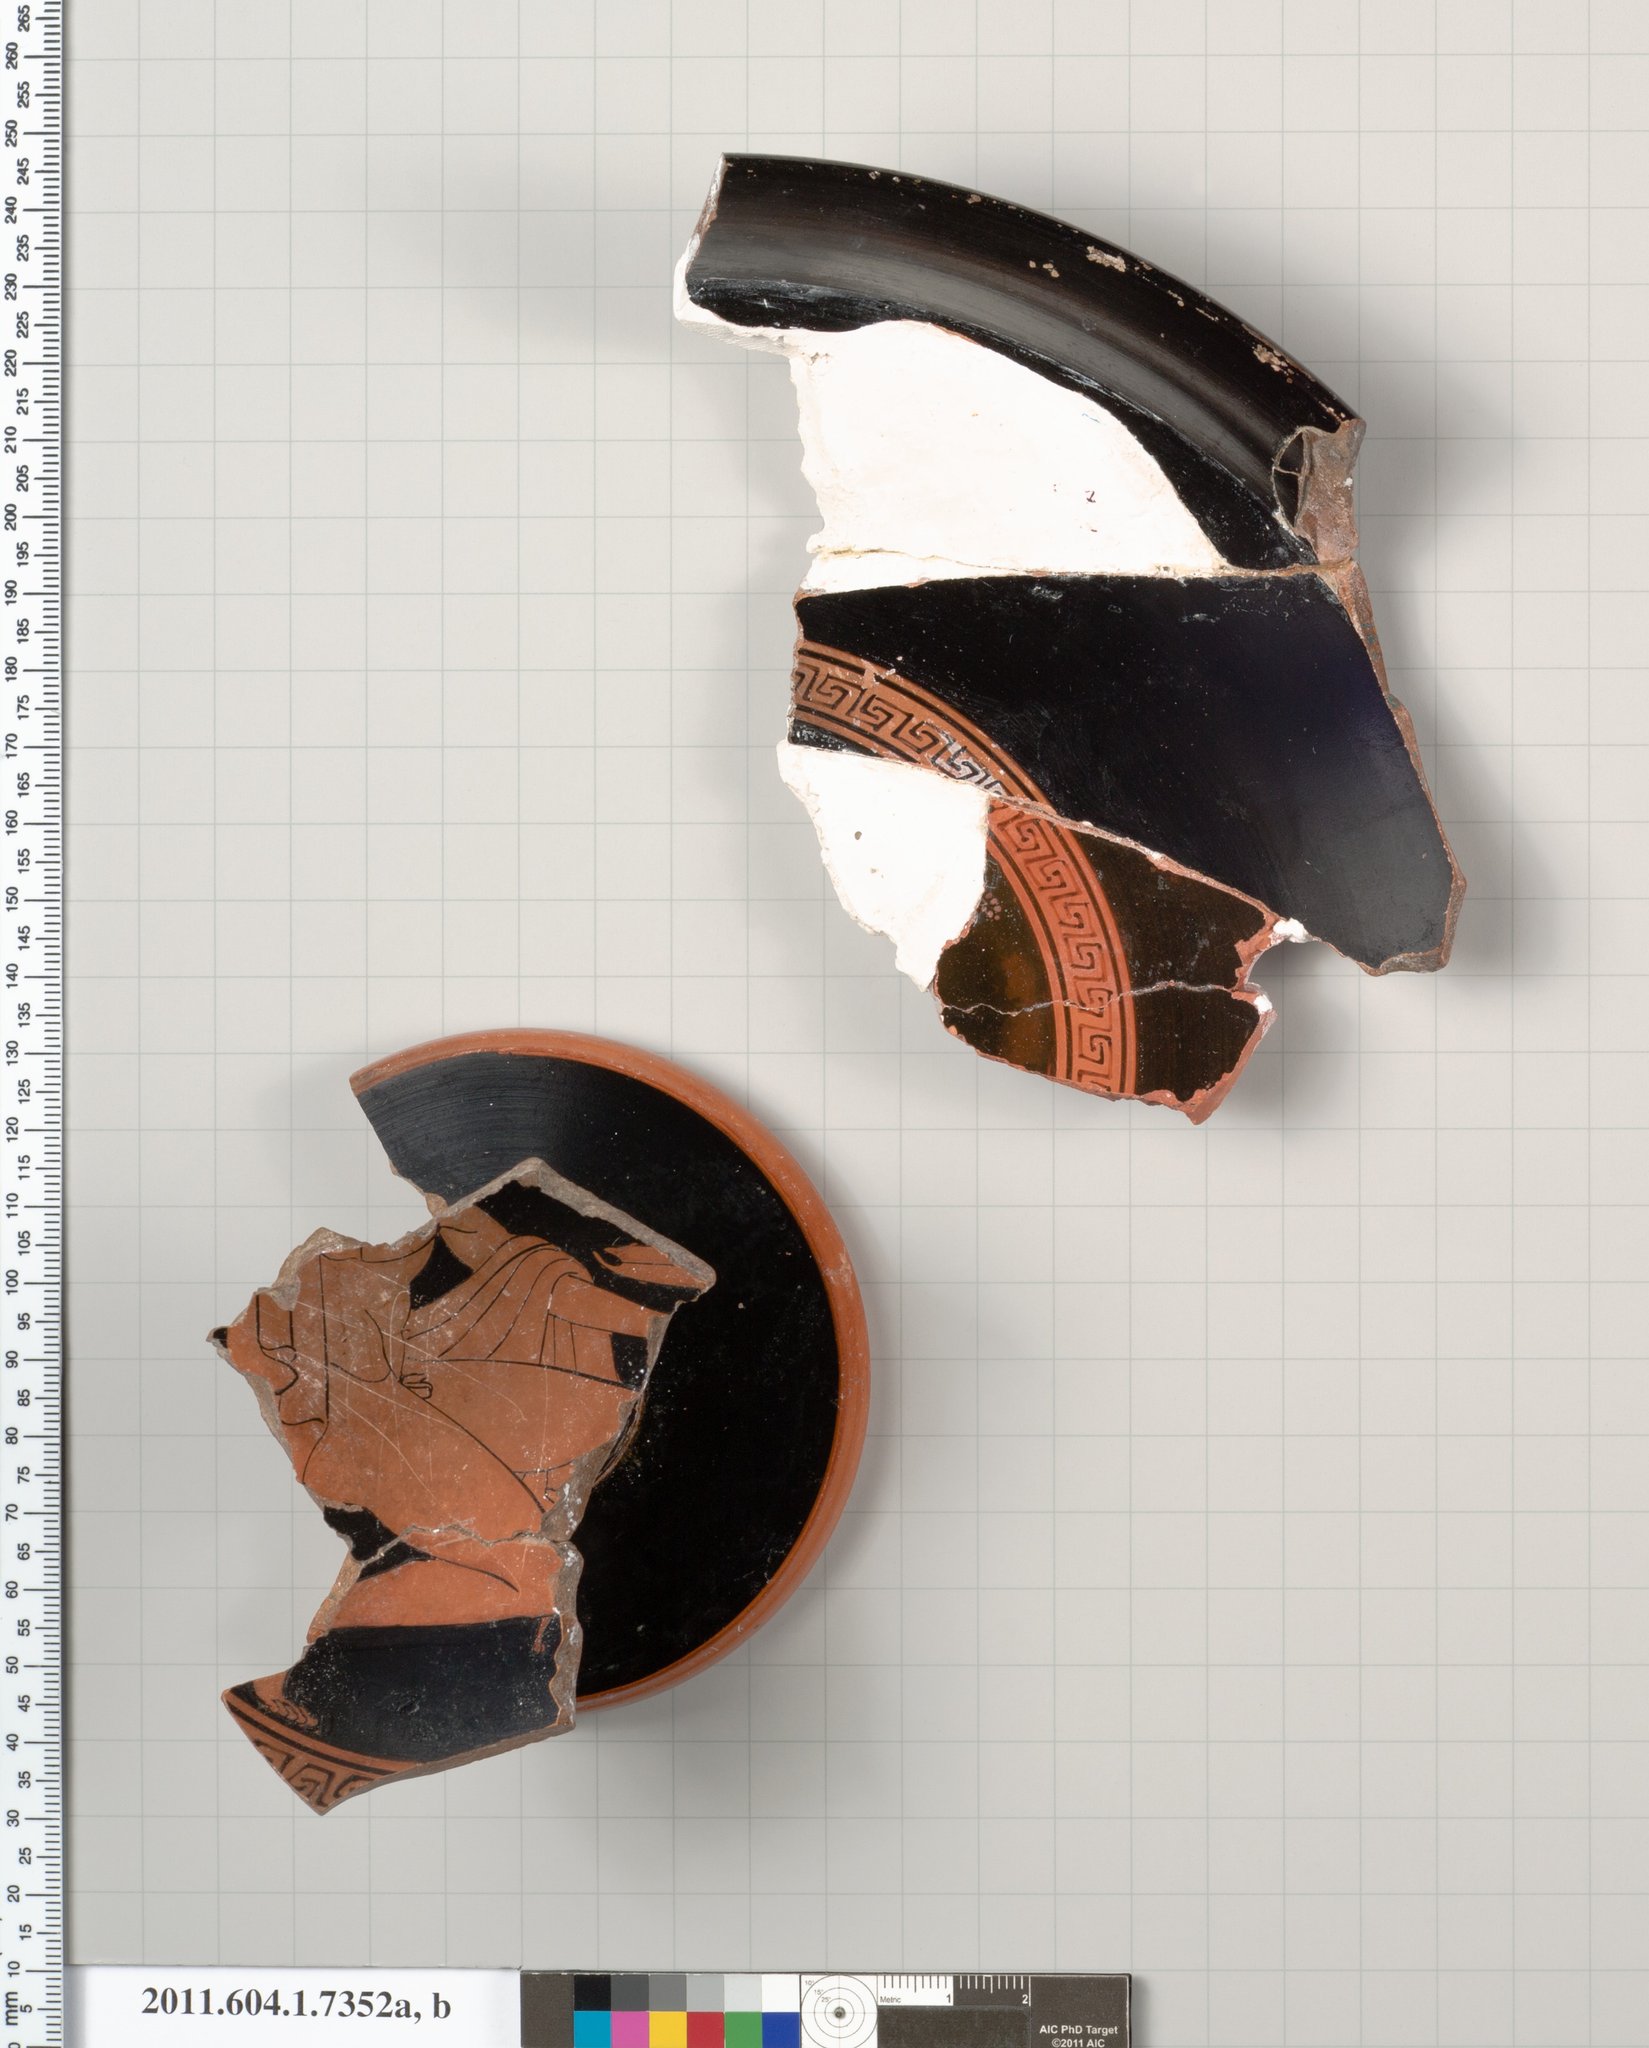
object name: kylix fragment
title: Terracotta fragments of a kylix (drinking cup)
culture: greek, attic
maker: makron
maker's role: artist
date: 500-480 BCE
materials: terracotta